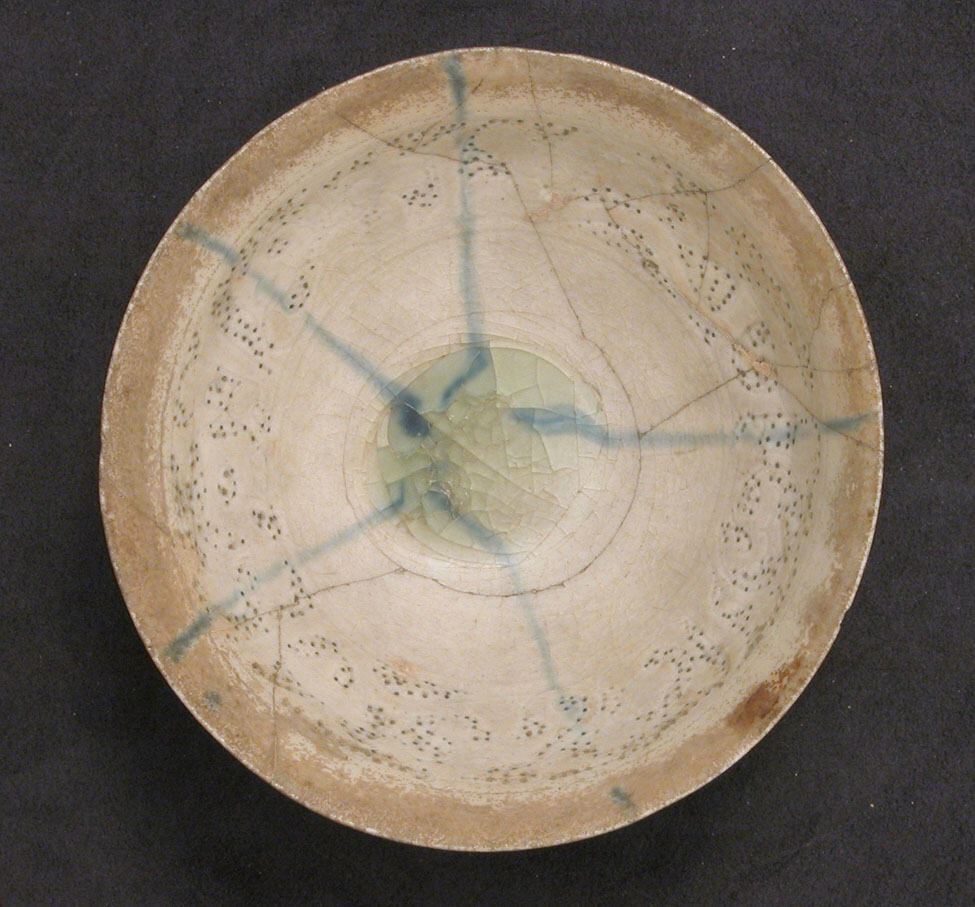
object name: bowl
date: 1101-1300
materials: stonepaste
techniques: glazing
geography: iran